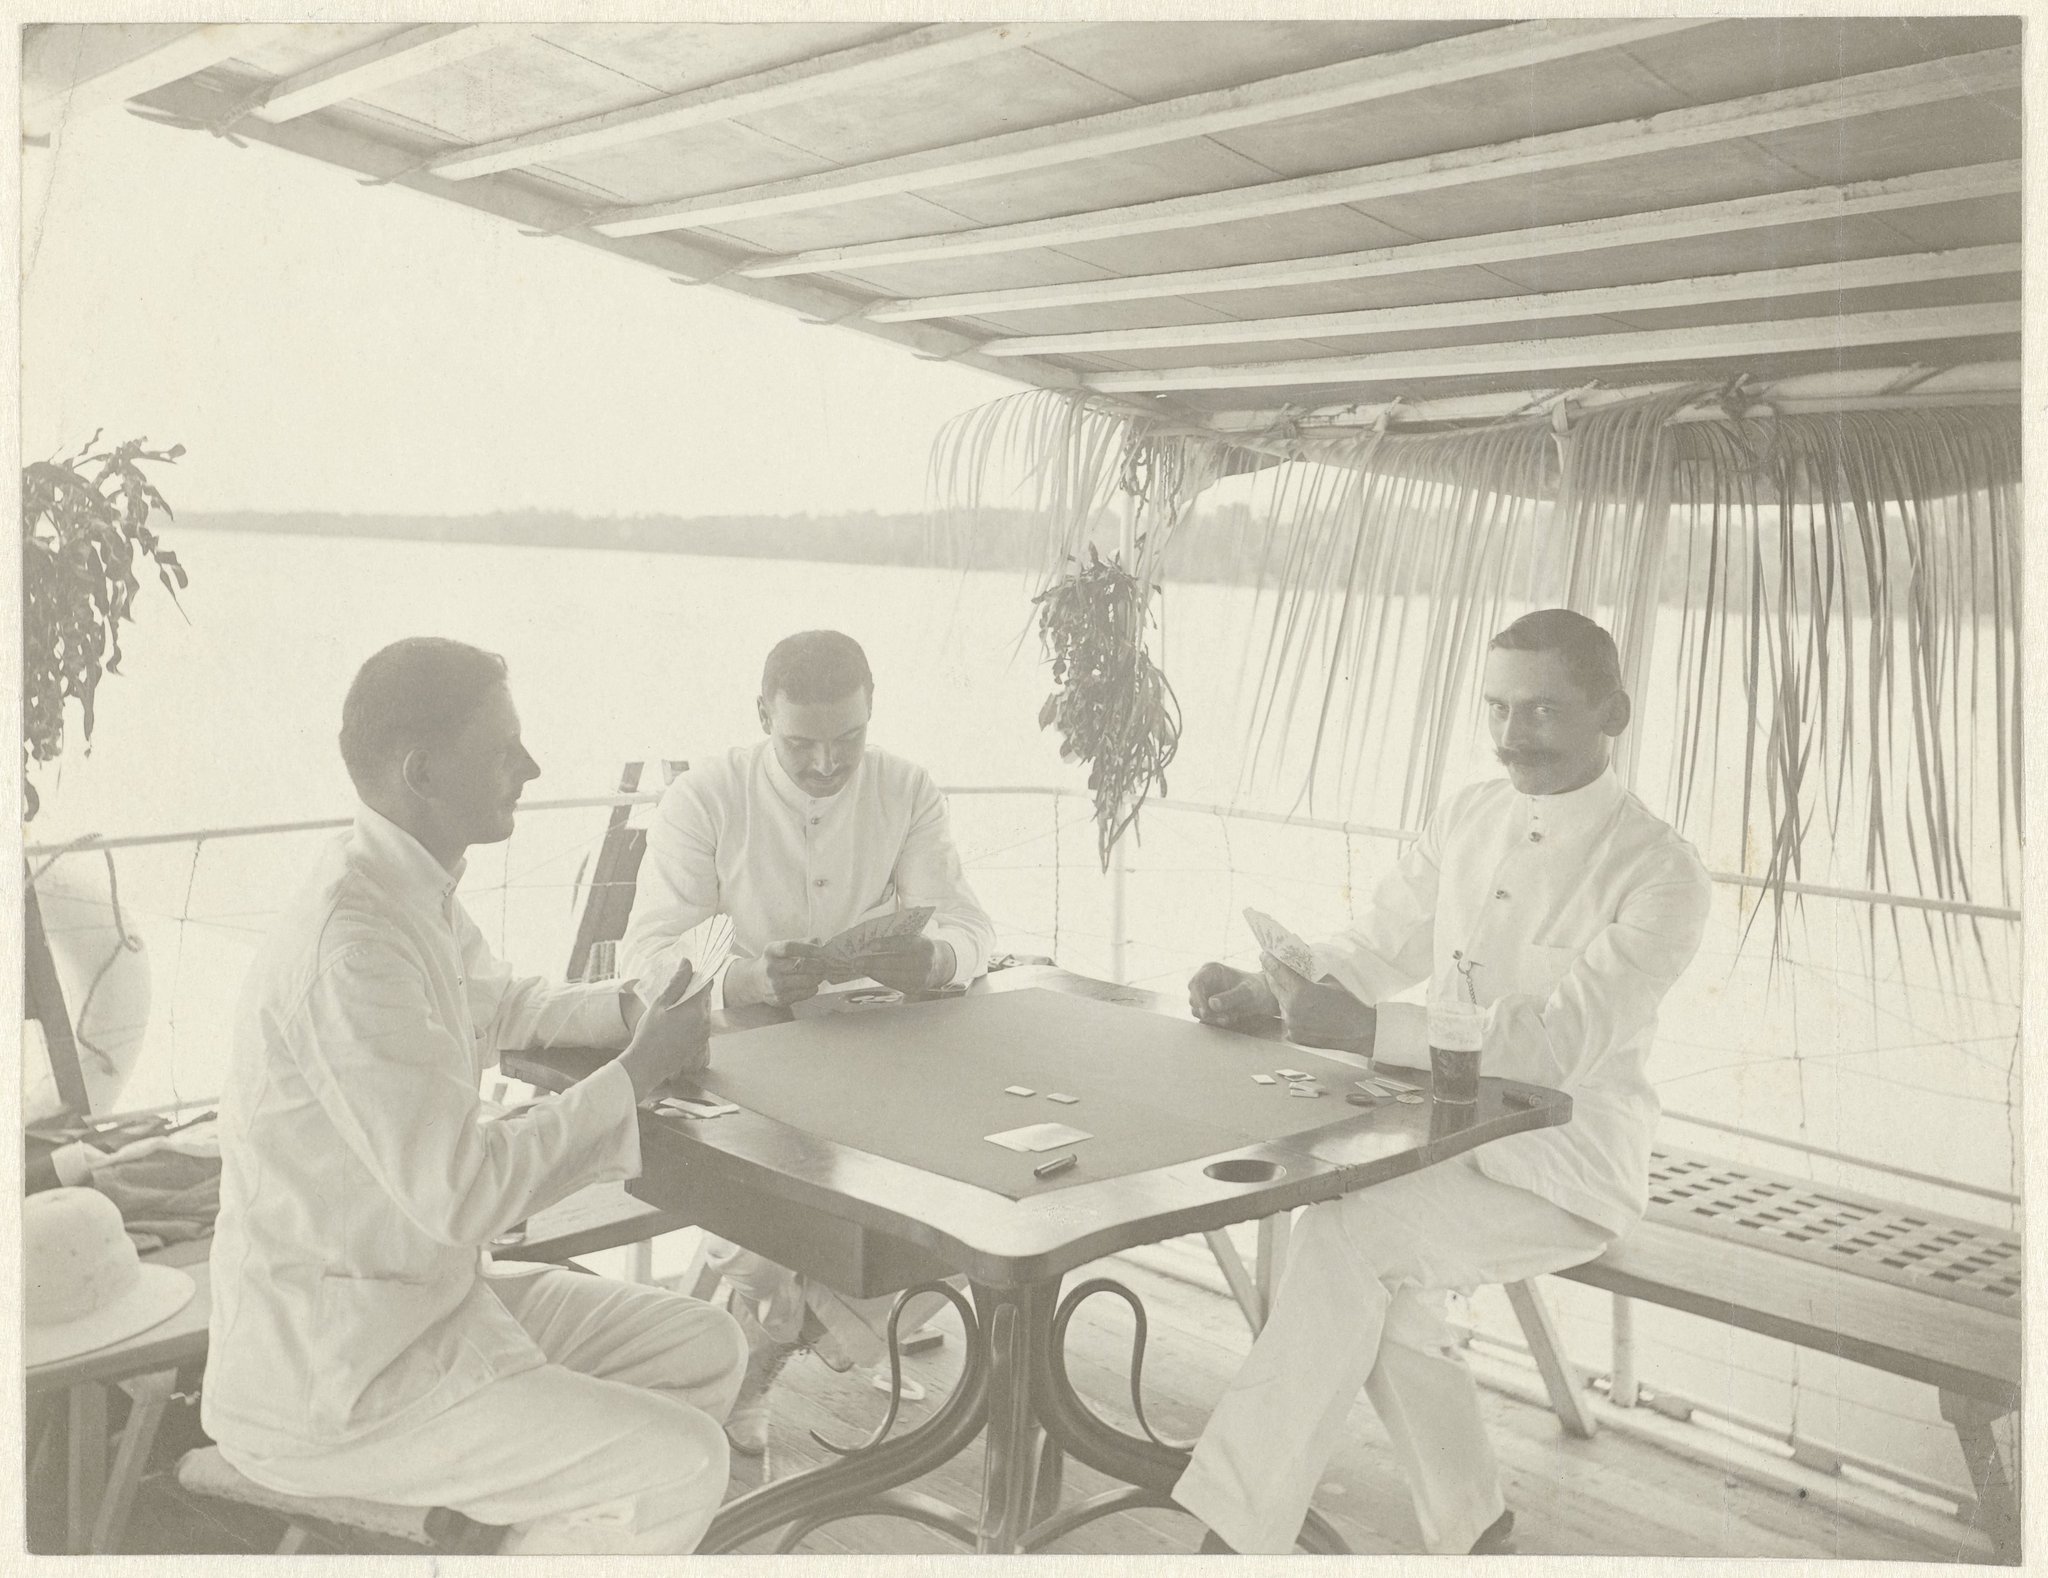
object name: photograph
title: Albert Glaser kaartend met twee vrienden op een boot, Langkat Sumatra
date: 1895-1905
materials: paper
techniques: platinum process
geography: bindjai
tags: playing-cards, sumatra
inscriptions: inscription: ‘Albert Glaser (zie Mitte)/ Bruder van Lucie Sandel, geb. Glaser/ (Frau van Paul Sandel)’, check stamp: ‘H. Ernst & Co./ Bindjey Langkat’